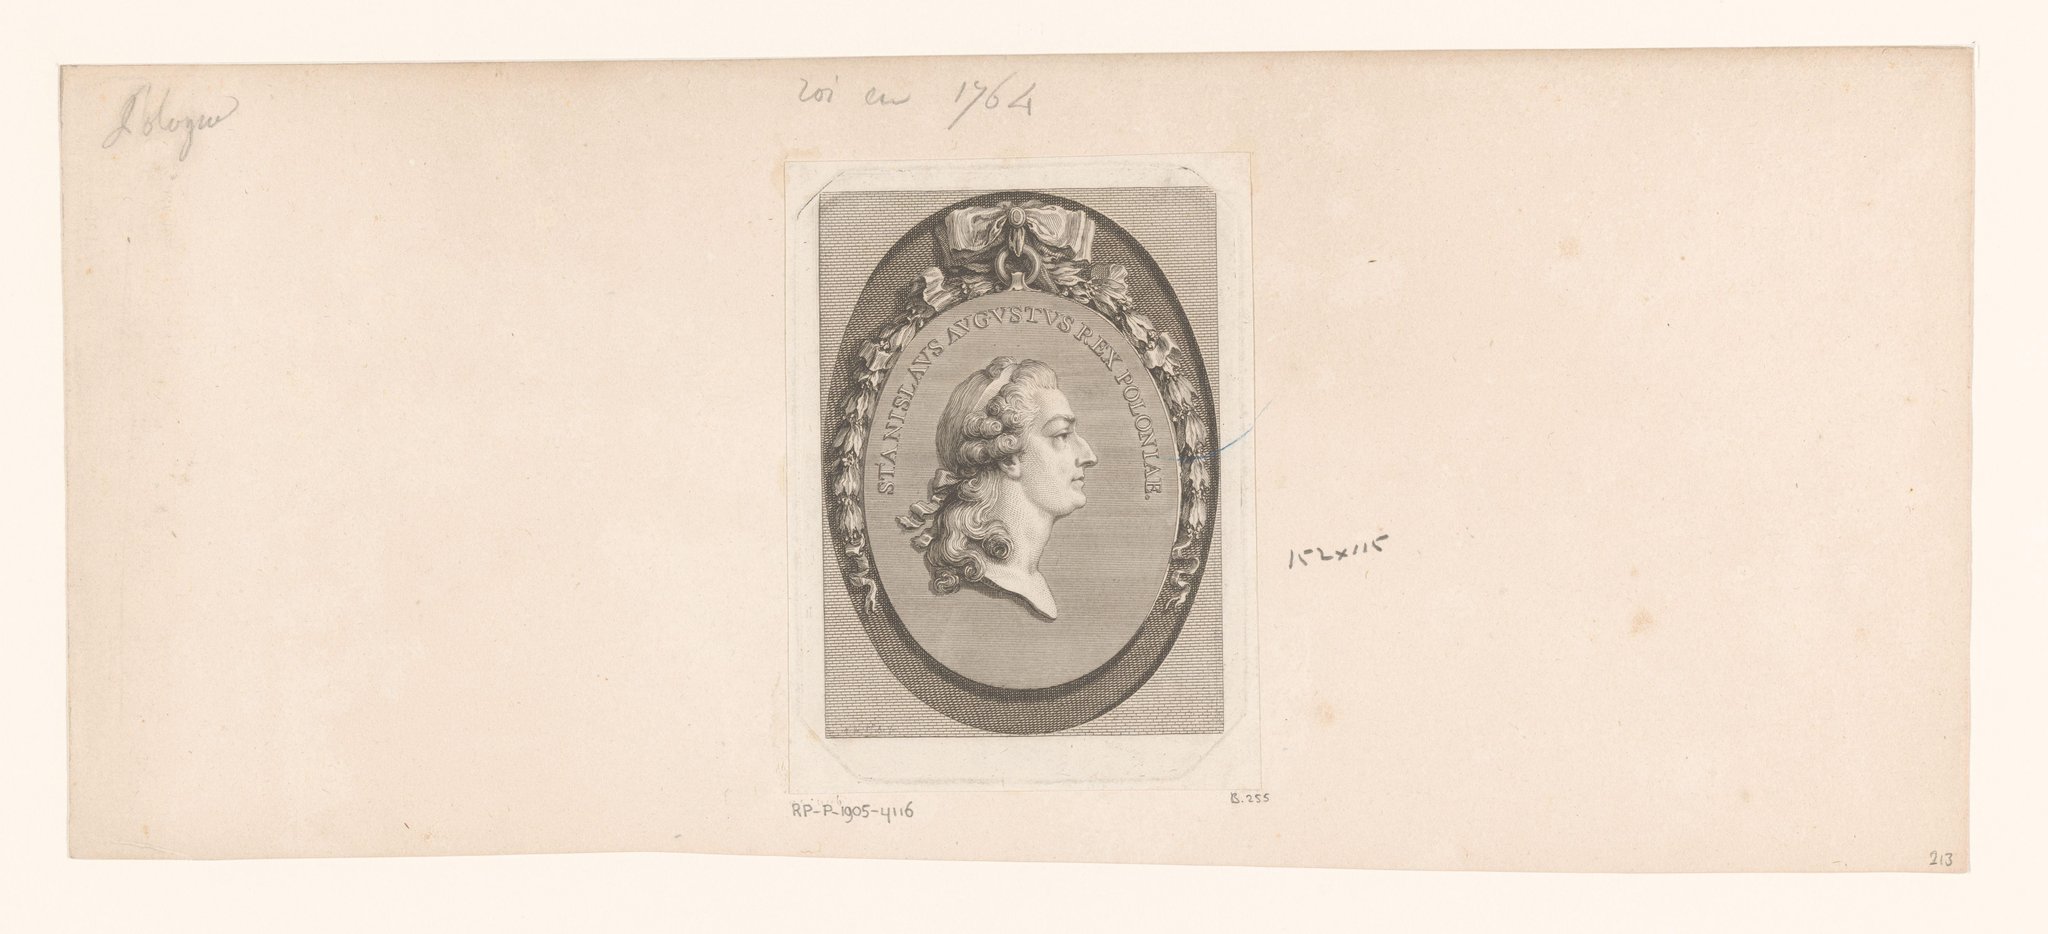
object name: print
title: Portret van Stanislaus II Augustus van Polen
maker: augustin de saint-aubin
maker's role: draughtsman, print maker, publisher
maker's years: 1736-1807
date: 1781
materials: paper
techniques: engraving, etching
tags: historical persons, king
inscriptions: collector's mark: Lugt 2228